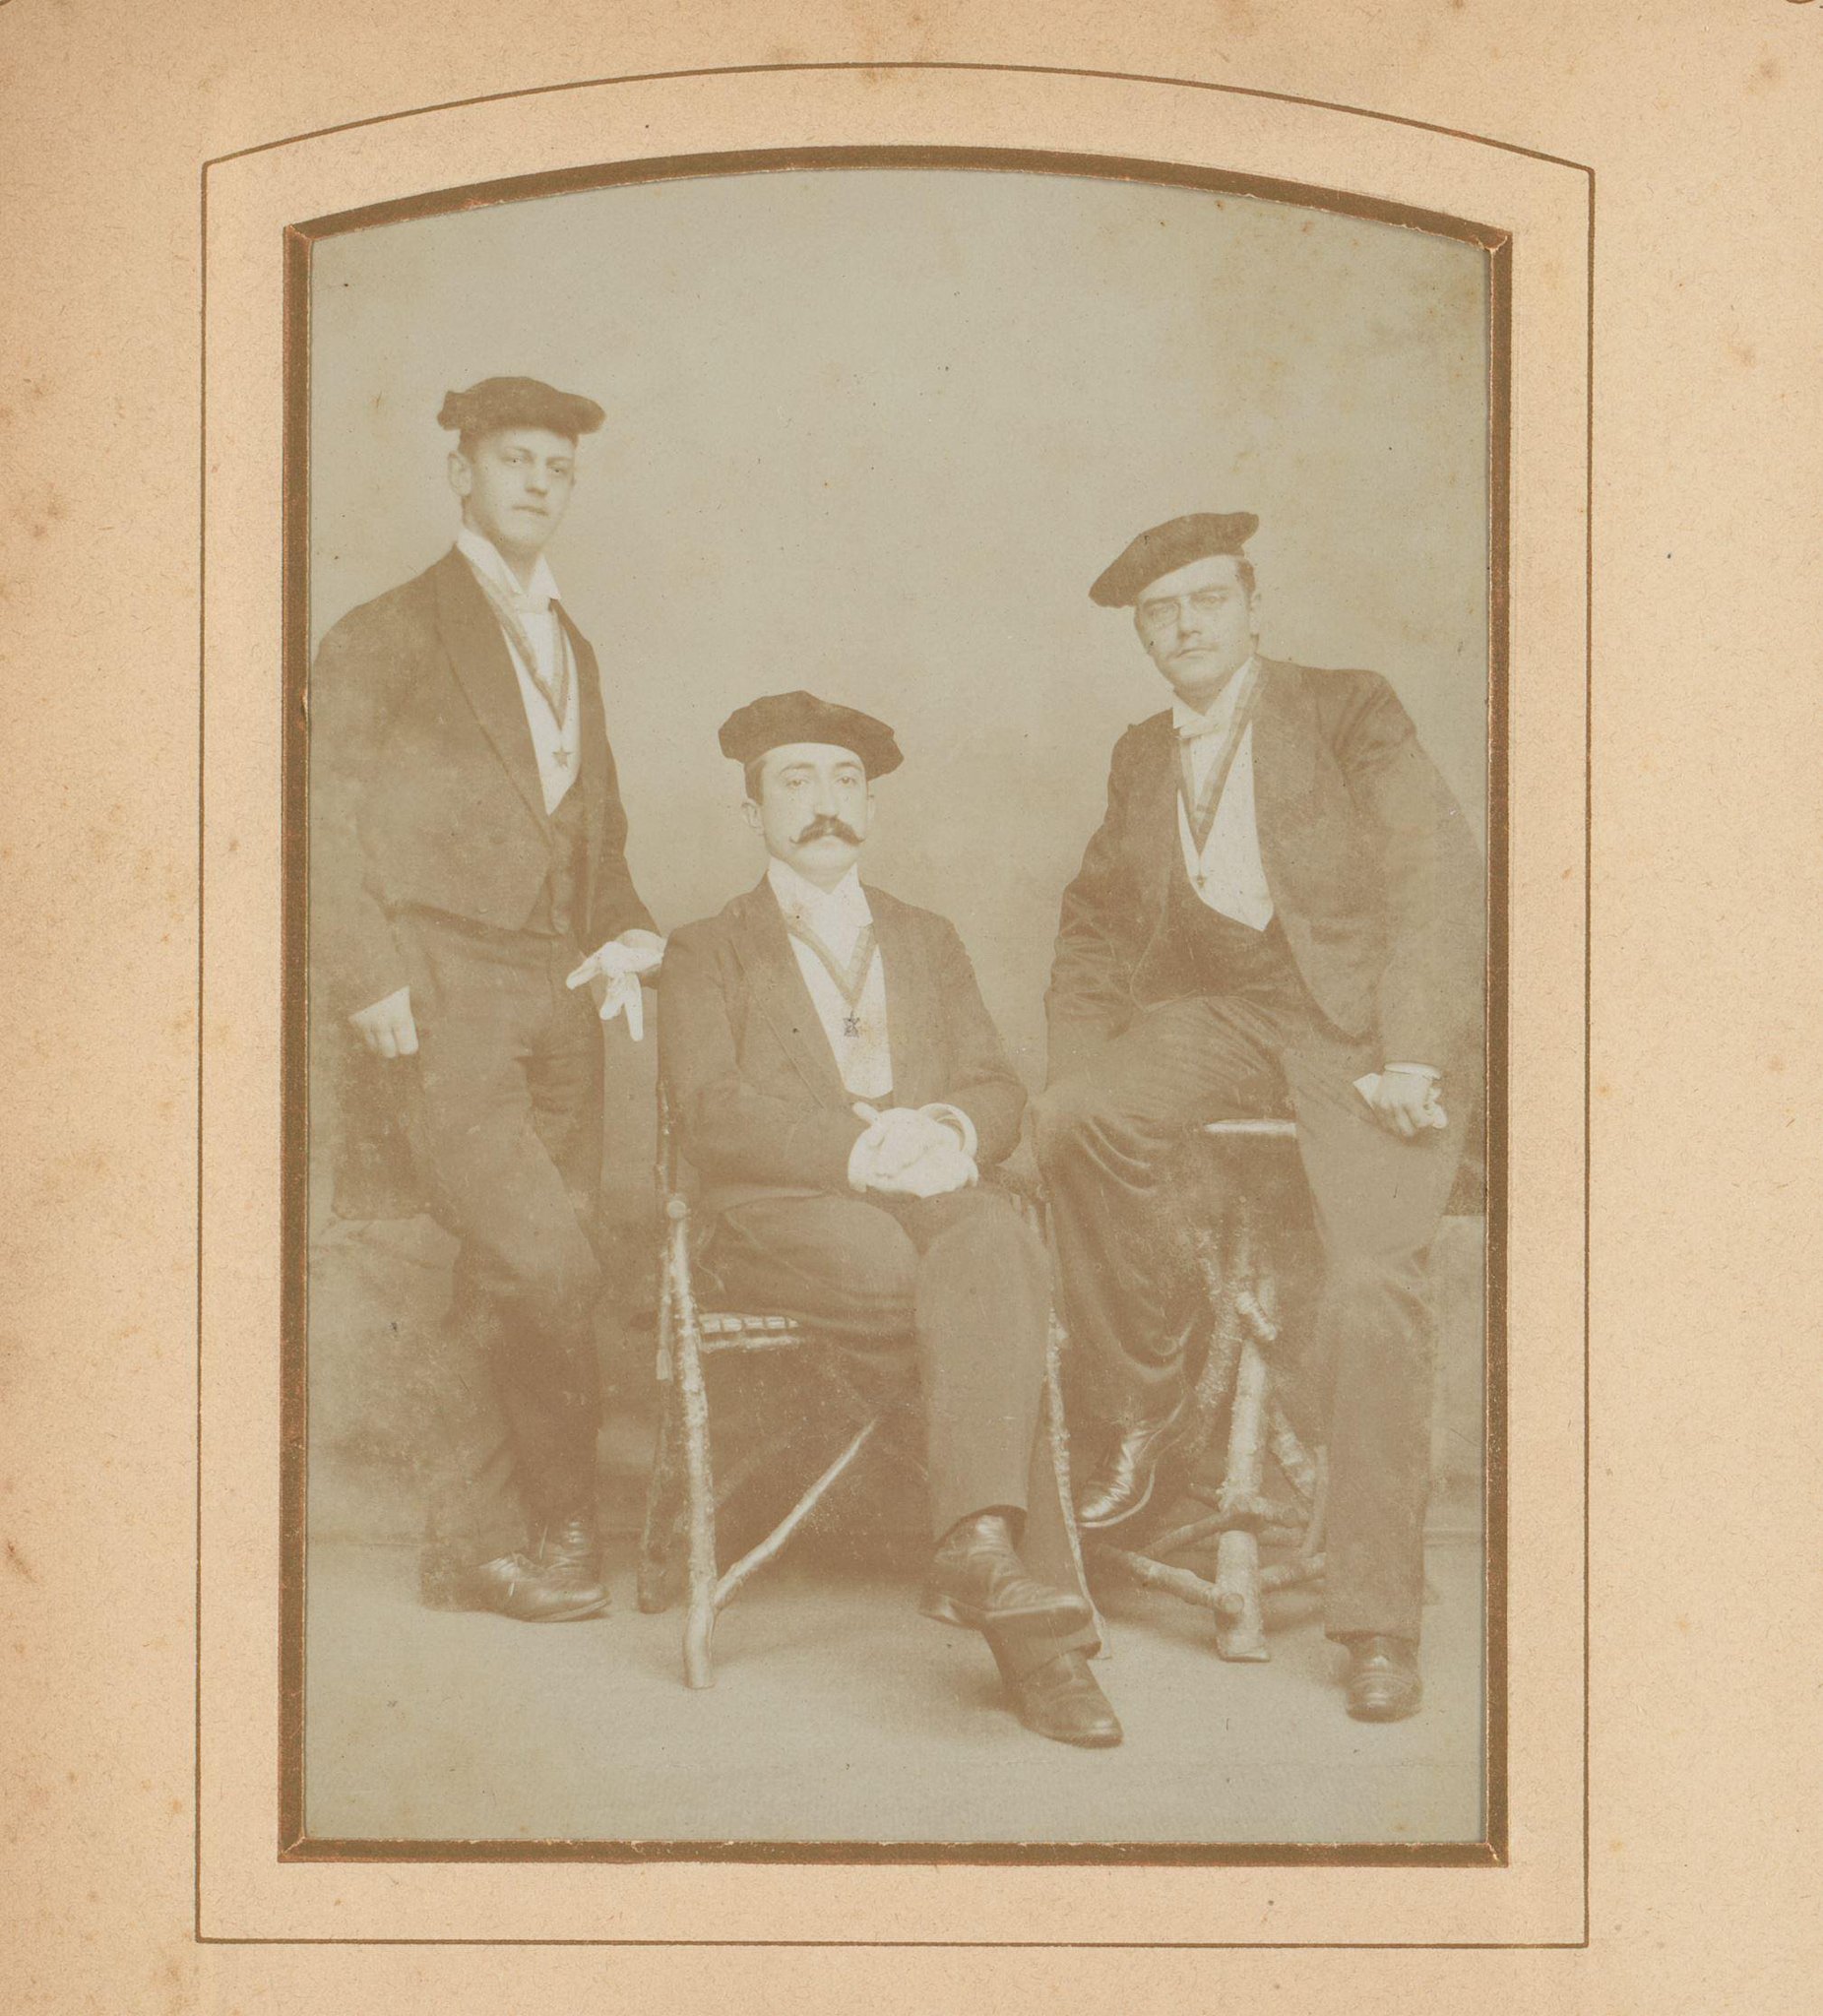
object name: album leaf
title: Groepsfoto van drie studenten, waaronder François Buys zittend in het midden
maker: nicolaas schuitvlot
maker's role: fotograaf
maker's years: 1859-1947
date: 1881-1890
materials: paper, cardboard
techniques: collodion silver print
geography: amsterdam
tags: françois buys, historical persons, student life, anonymous historical persons portrayed in a group, in a group-portrait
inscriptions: address: ‘Amsterdam/ Paleisstraat bij den Dam No 5.’